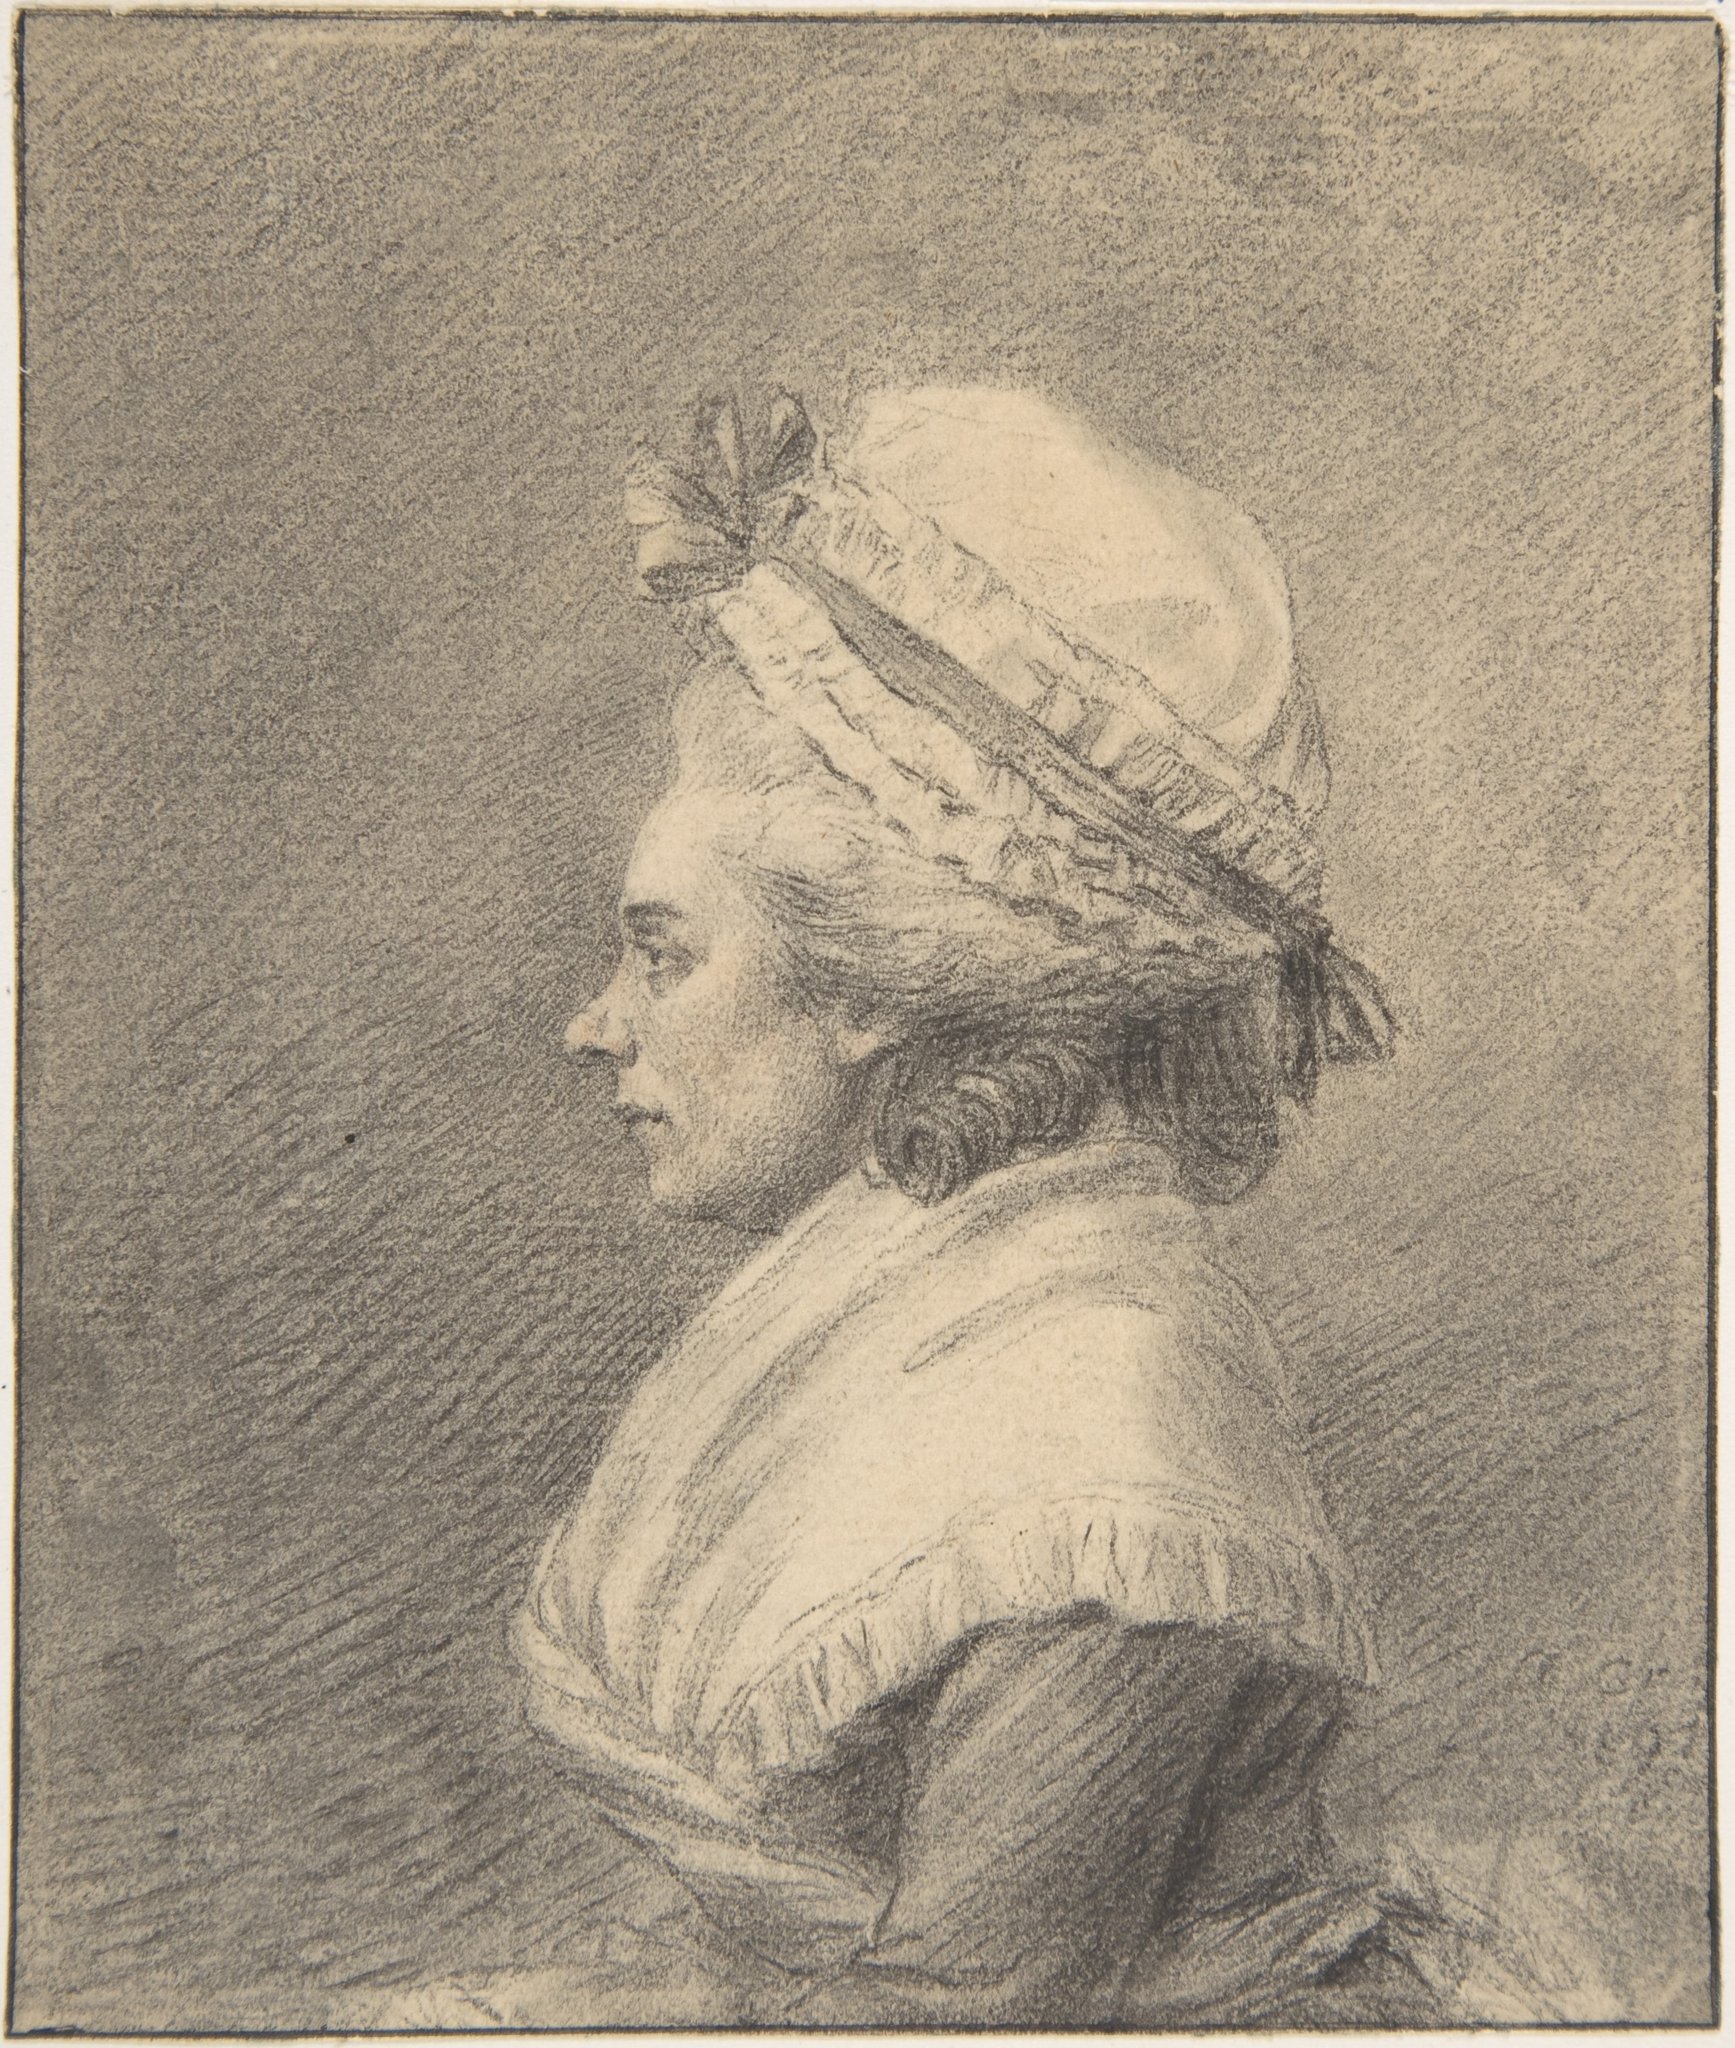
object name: drawing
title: Profile of a Lady in a Bonnet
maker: augustin de saint-aubin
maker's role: artist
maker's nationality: french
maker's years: 1736-1807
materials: chalk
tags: portraits,women